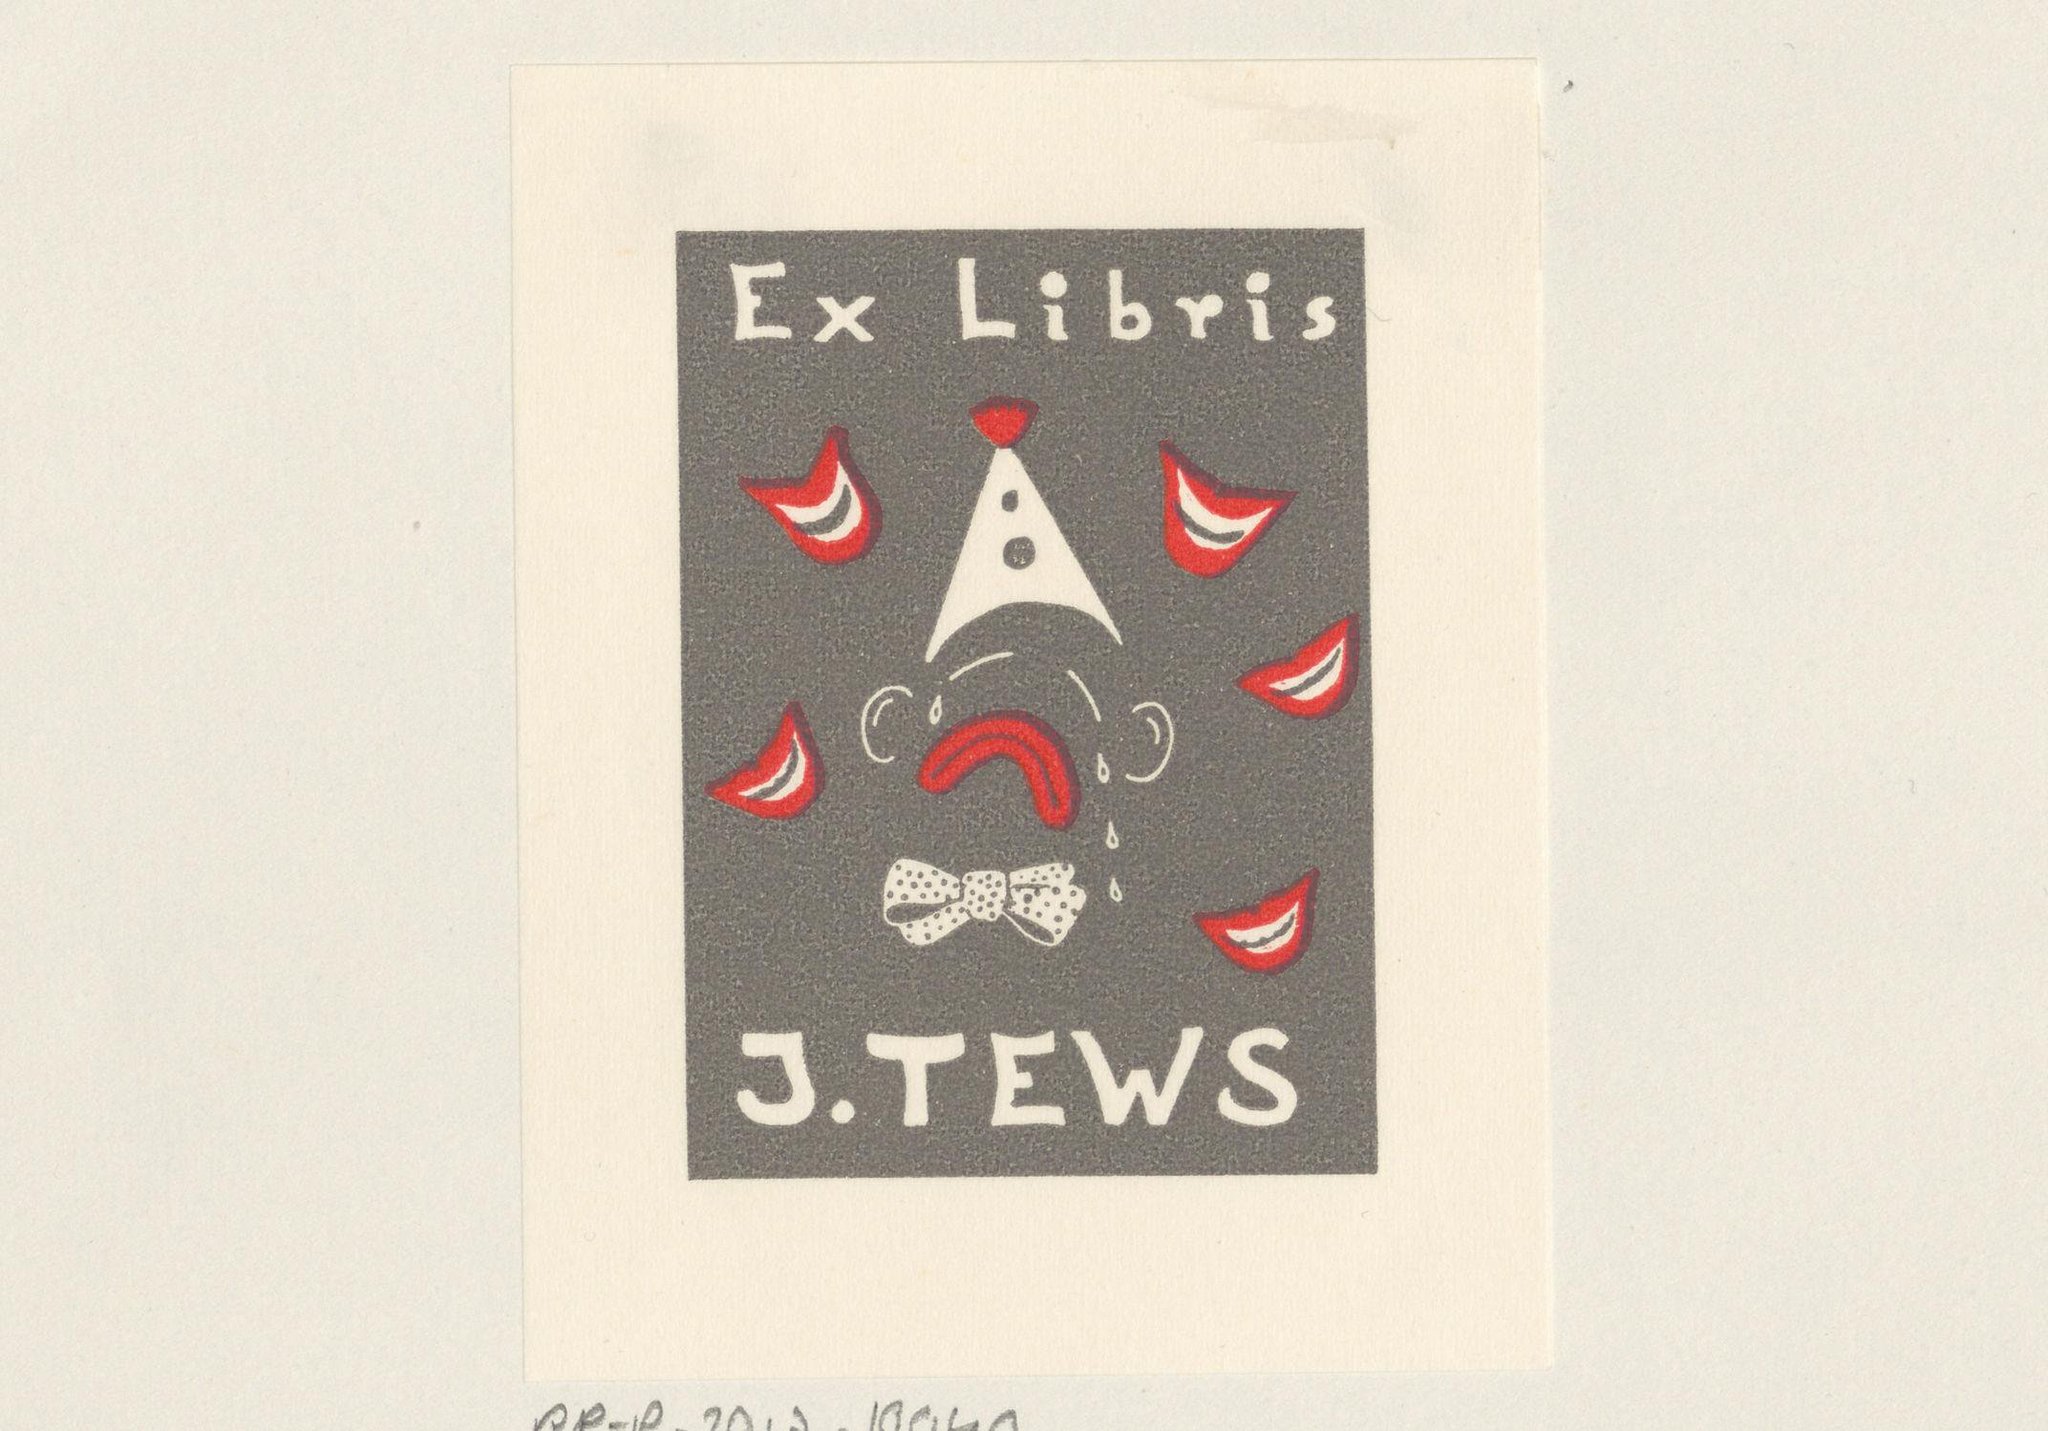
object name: bookplate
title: Ex libris van Jørgen Tews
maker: Anonymous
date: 1900-1999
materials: paper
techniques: printing block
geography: denmark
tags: clown, 'tragedia' (ripa)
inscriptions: inscription: ‘Ole Dich/ Denemark’